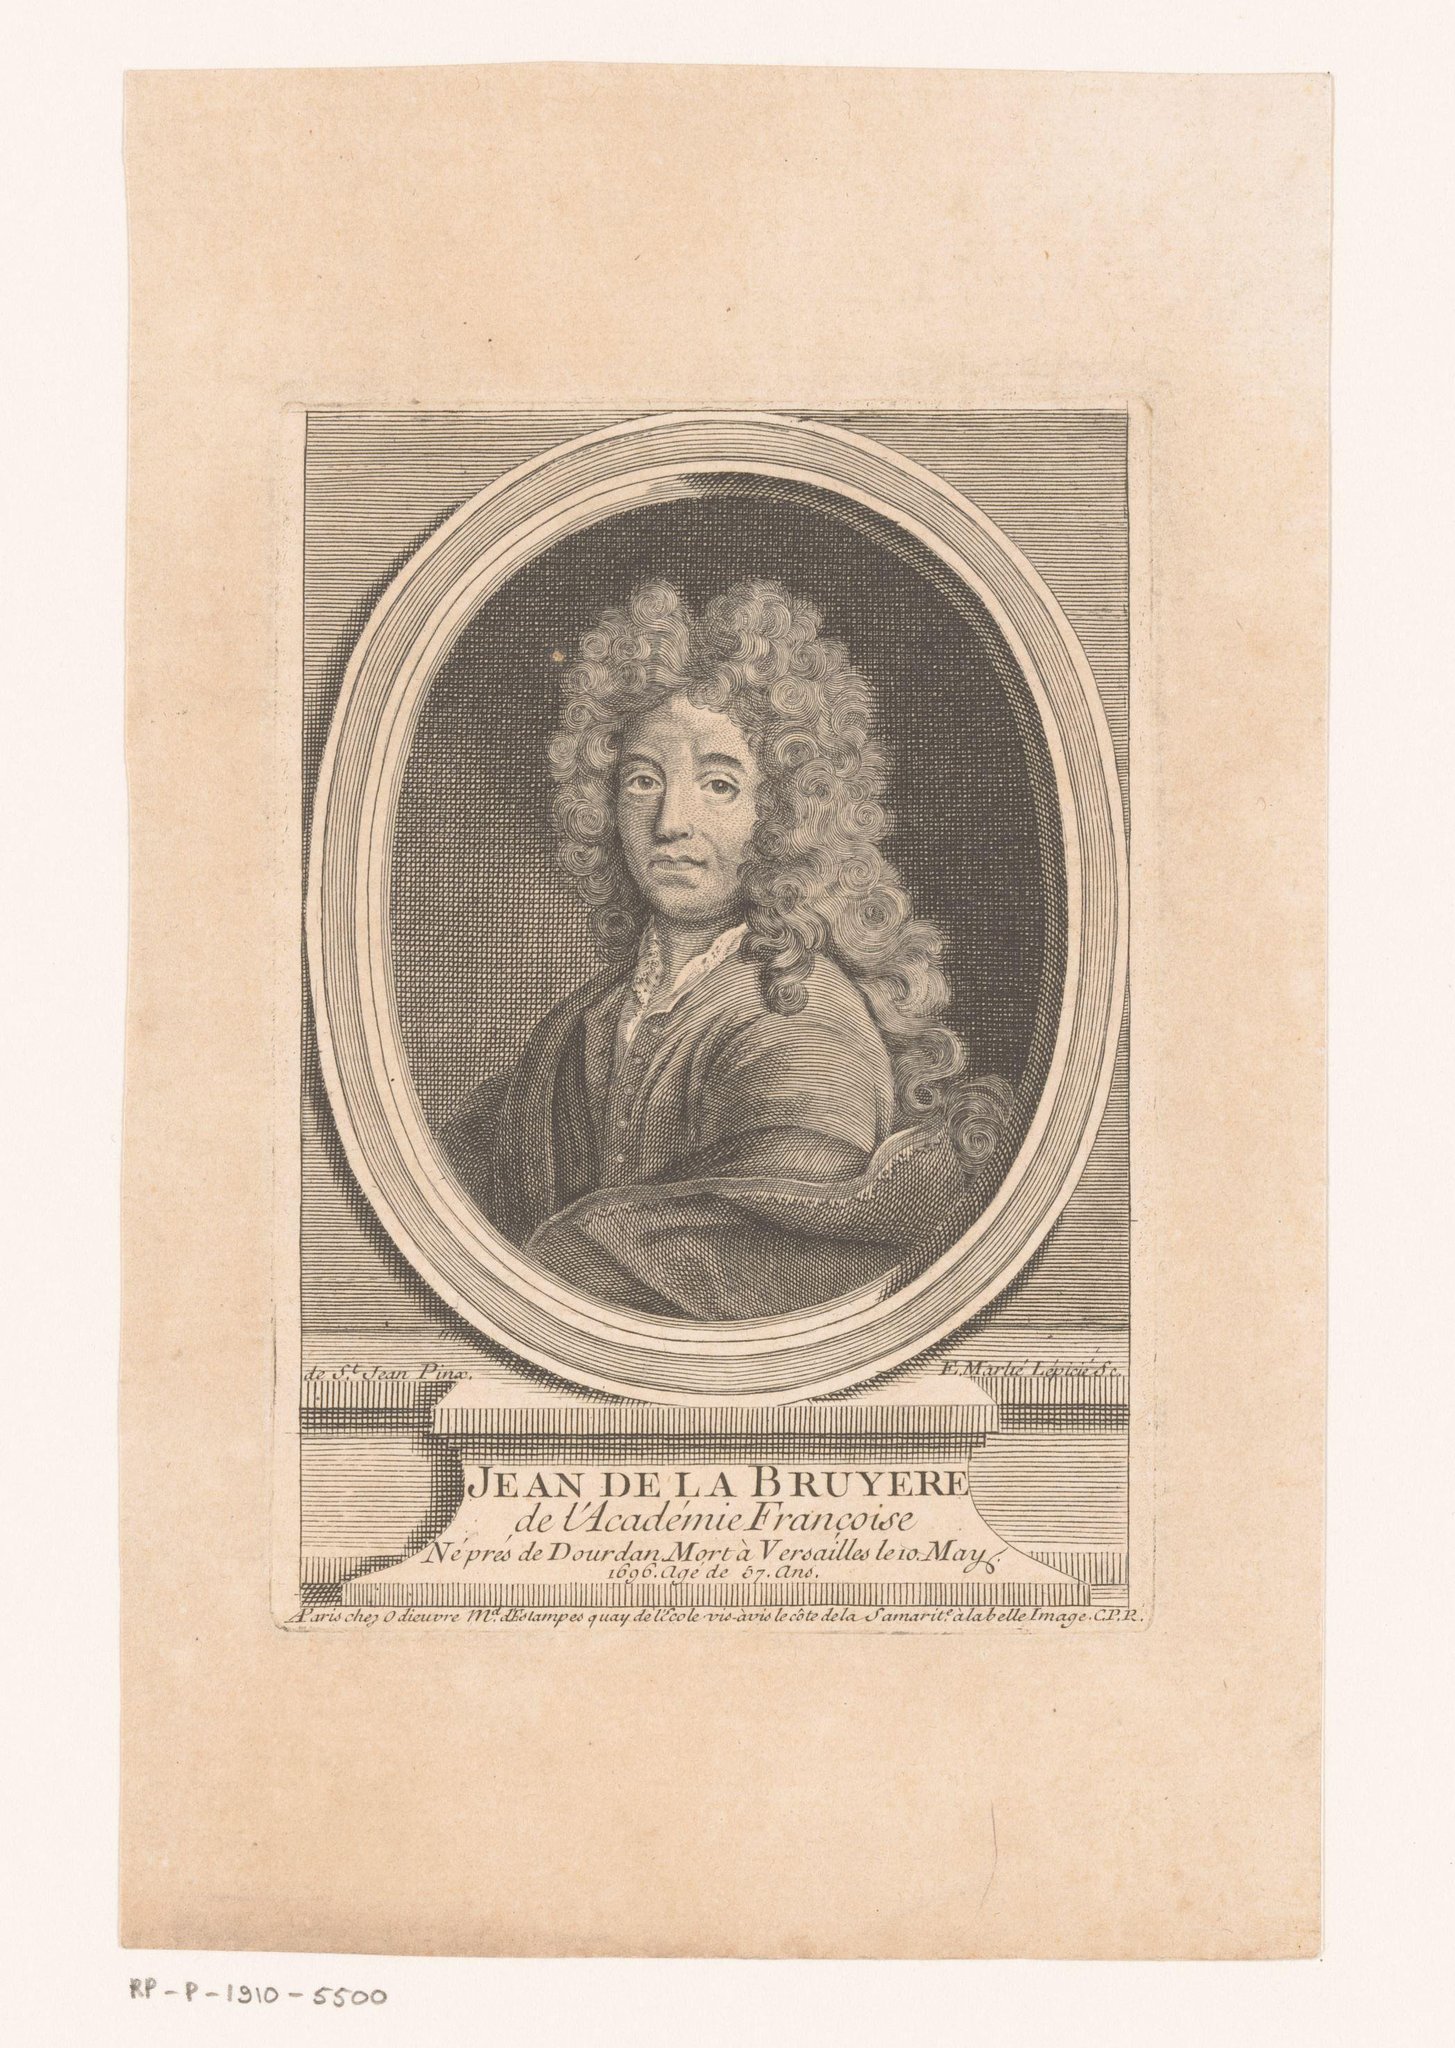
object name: print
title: Portret van Jean De la Bruyère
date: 1724-1756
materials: paper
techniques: engraving, etching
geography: france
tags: paris, historical persons, portrait of a writer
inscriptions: collector's mark: Lugt 2228